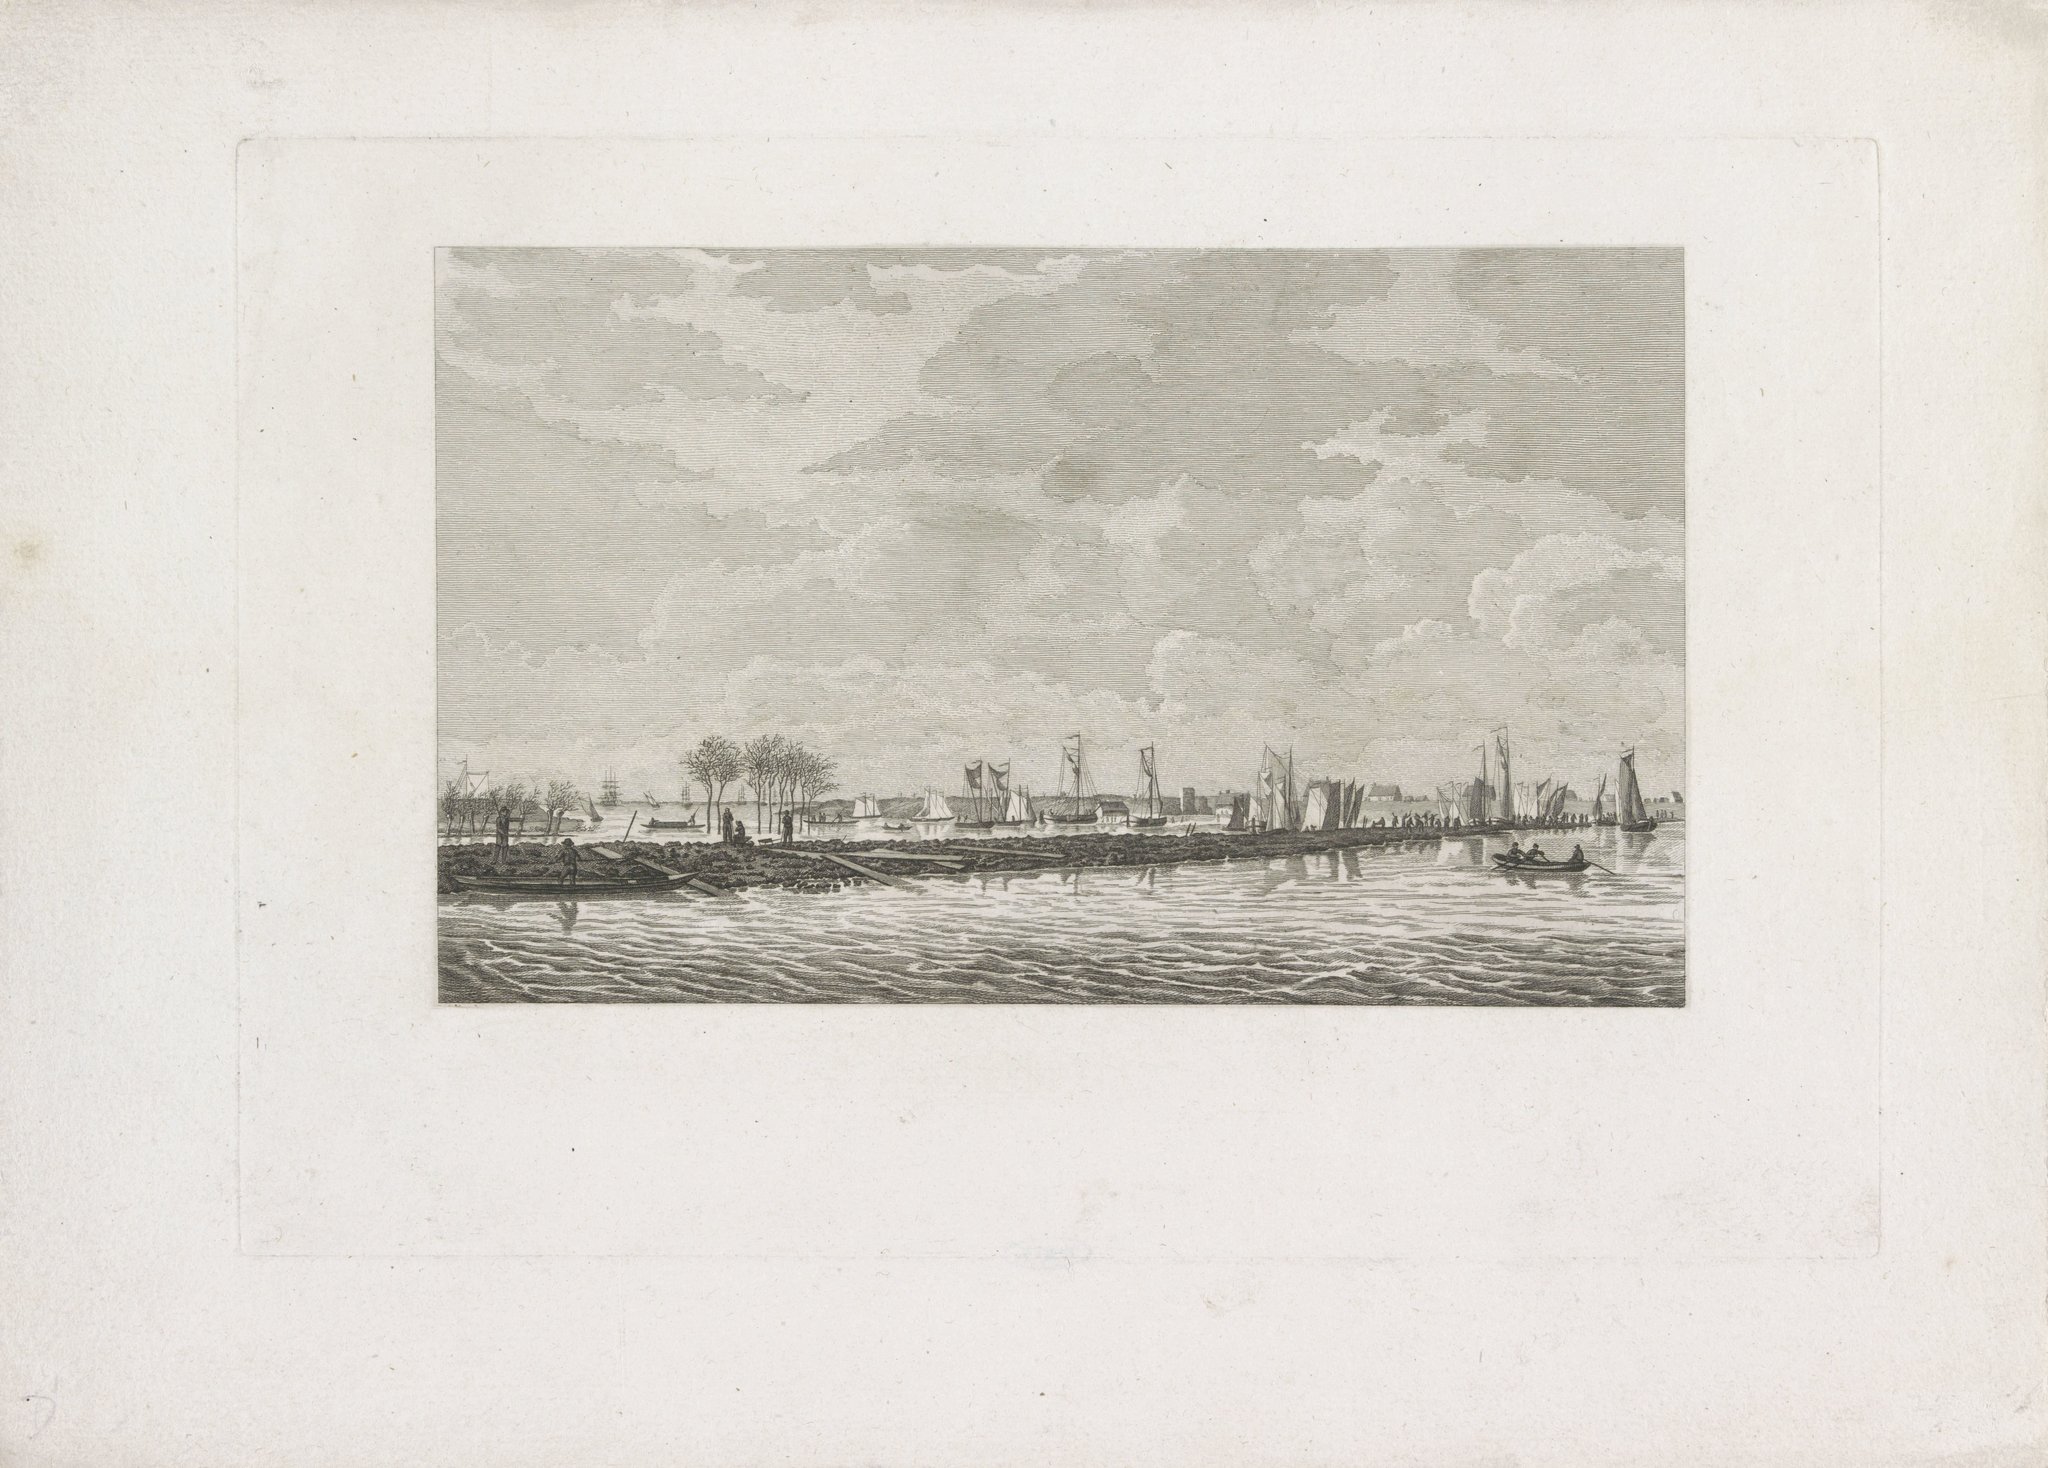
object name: print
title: Dichtmaken van de dijk te Kruiningen, 1808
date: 1808-1810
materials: paper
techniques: engraving, etching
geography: netherlands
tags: flood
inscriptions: collector's mark: Lugt 2228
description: Gebruikt als illustratie in: Sander van Hoek, Natuur- en geschiedkundige beschrijving van den verschrikkelijken watervloed tusschen den XIVden en XVden van louwmaand des jaars MDCCCVIII. 3 dln. Haarlem: Adriaan Loosjes Pz., 1808-1810.